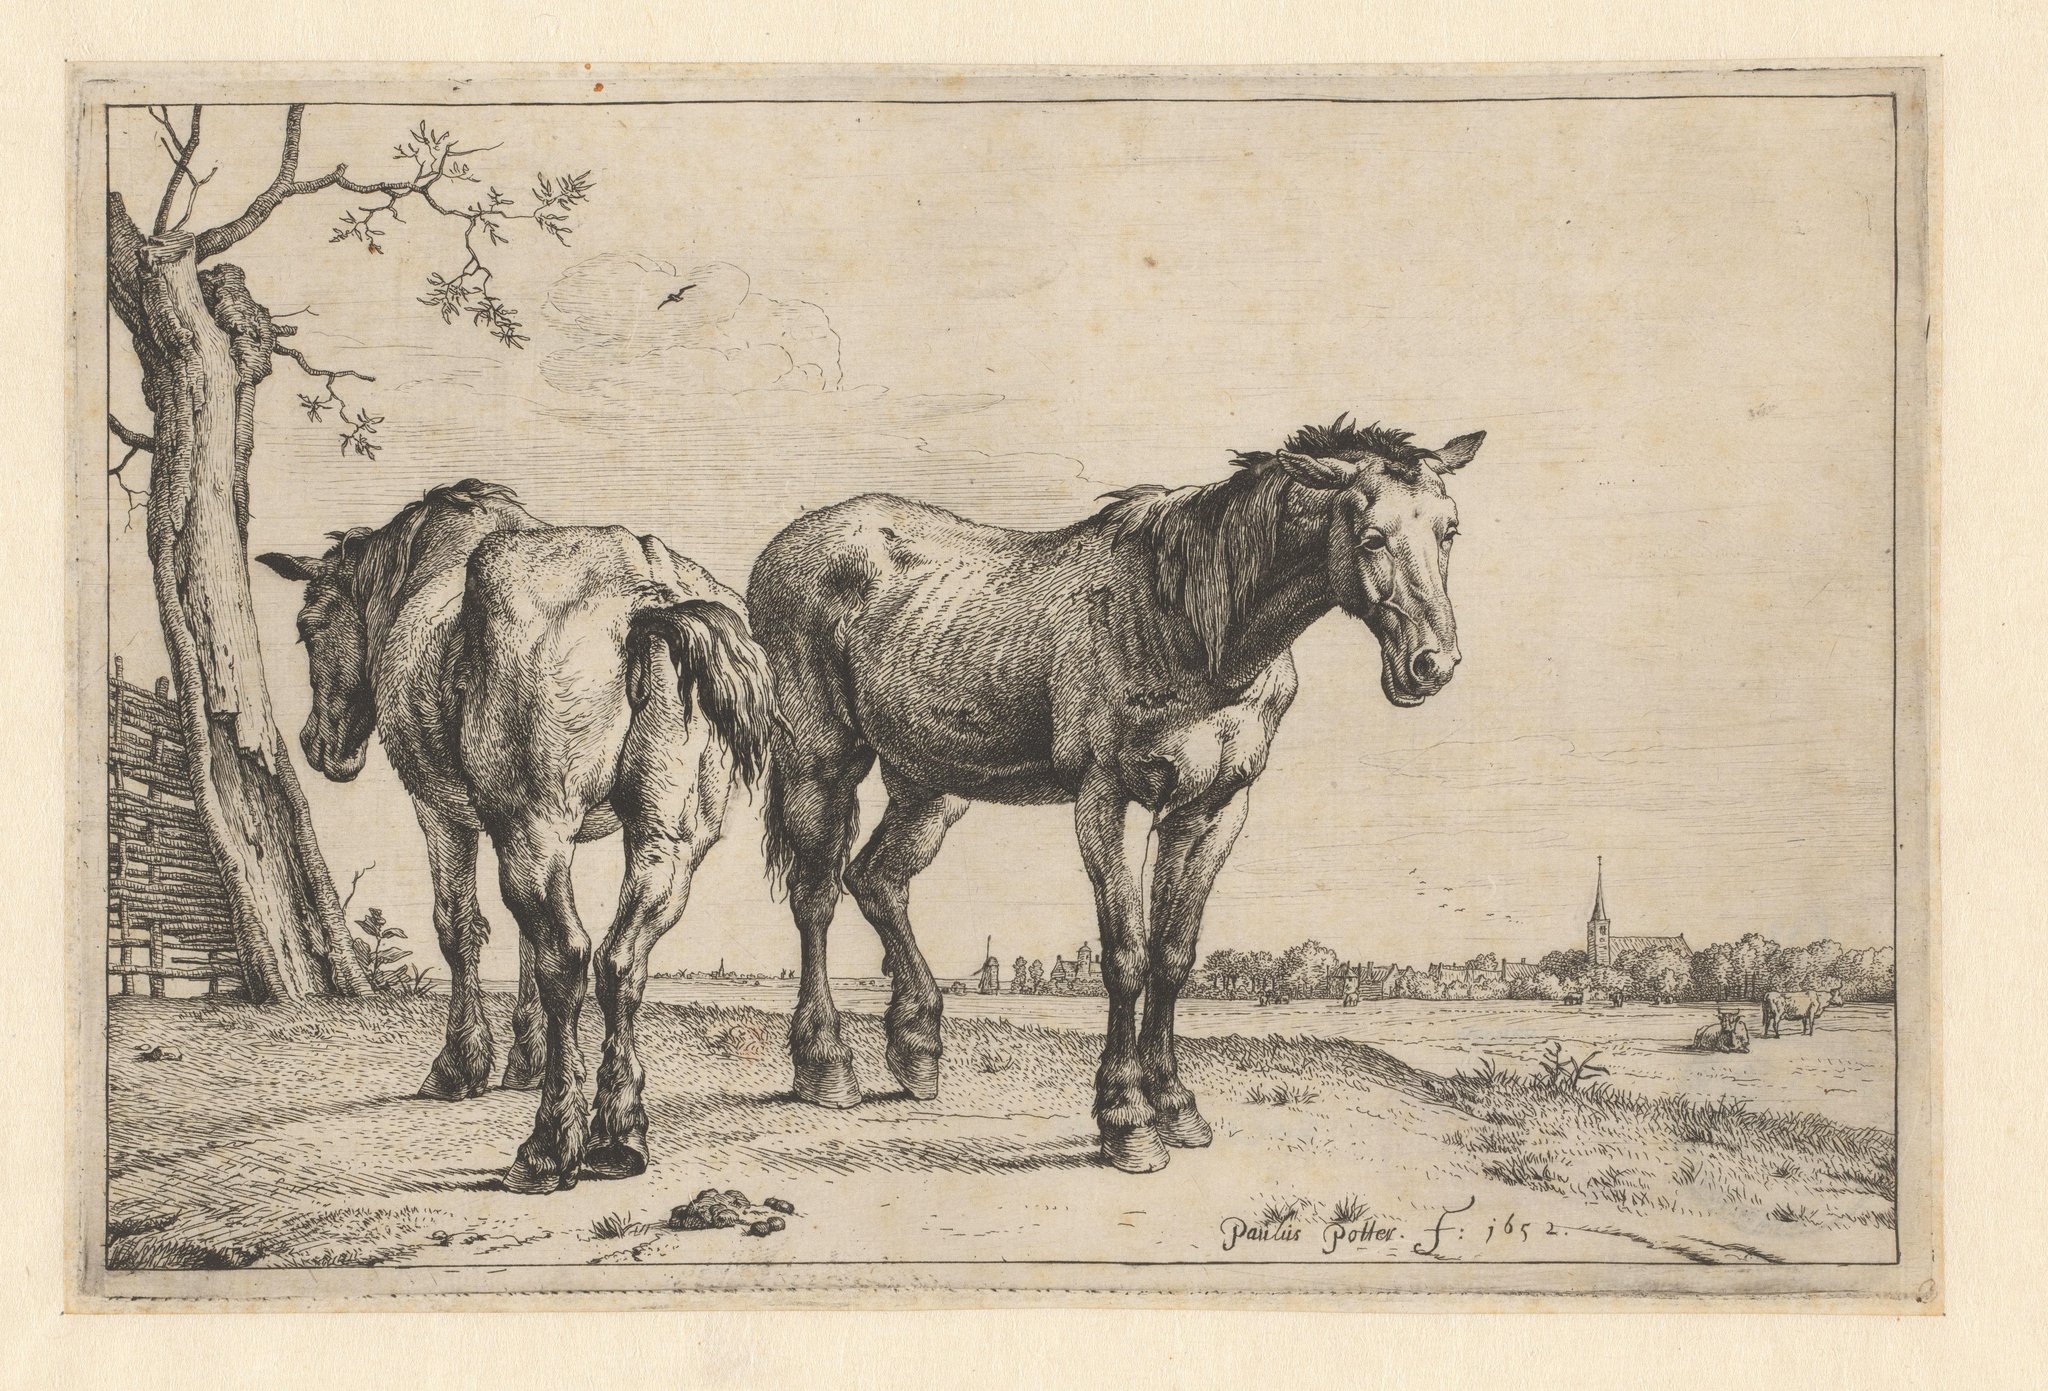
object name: print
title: Twee ploegpaarden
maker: paulus potter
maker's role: draughtsman, painter, print maker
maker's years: 1625-1654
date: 1652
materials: paper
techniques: etching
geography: netherlands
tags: horse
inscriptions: collector's mark: Lugt 11, collector's mark: Lugt 10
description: Twee werkpaarden staand bij een boom in een landschap.